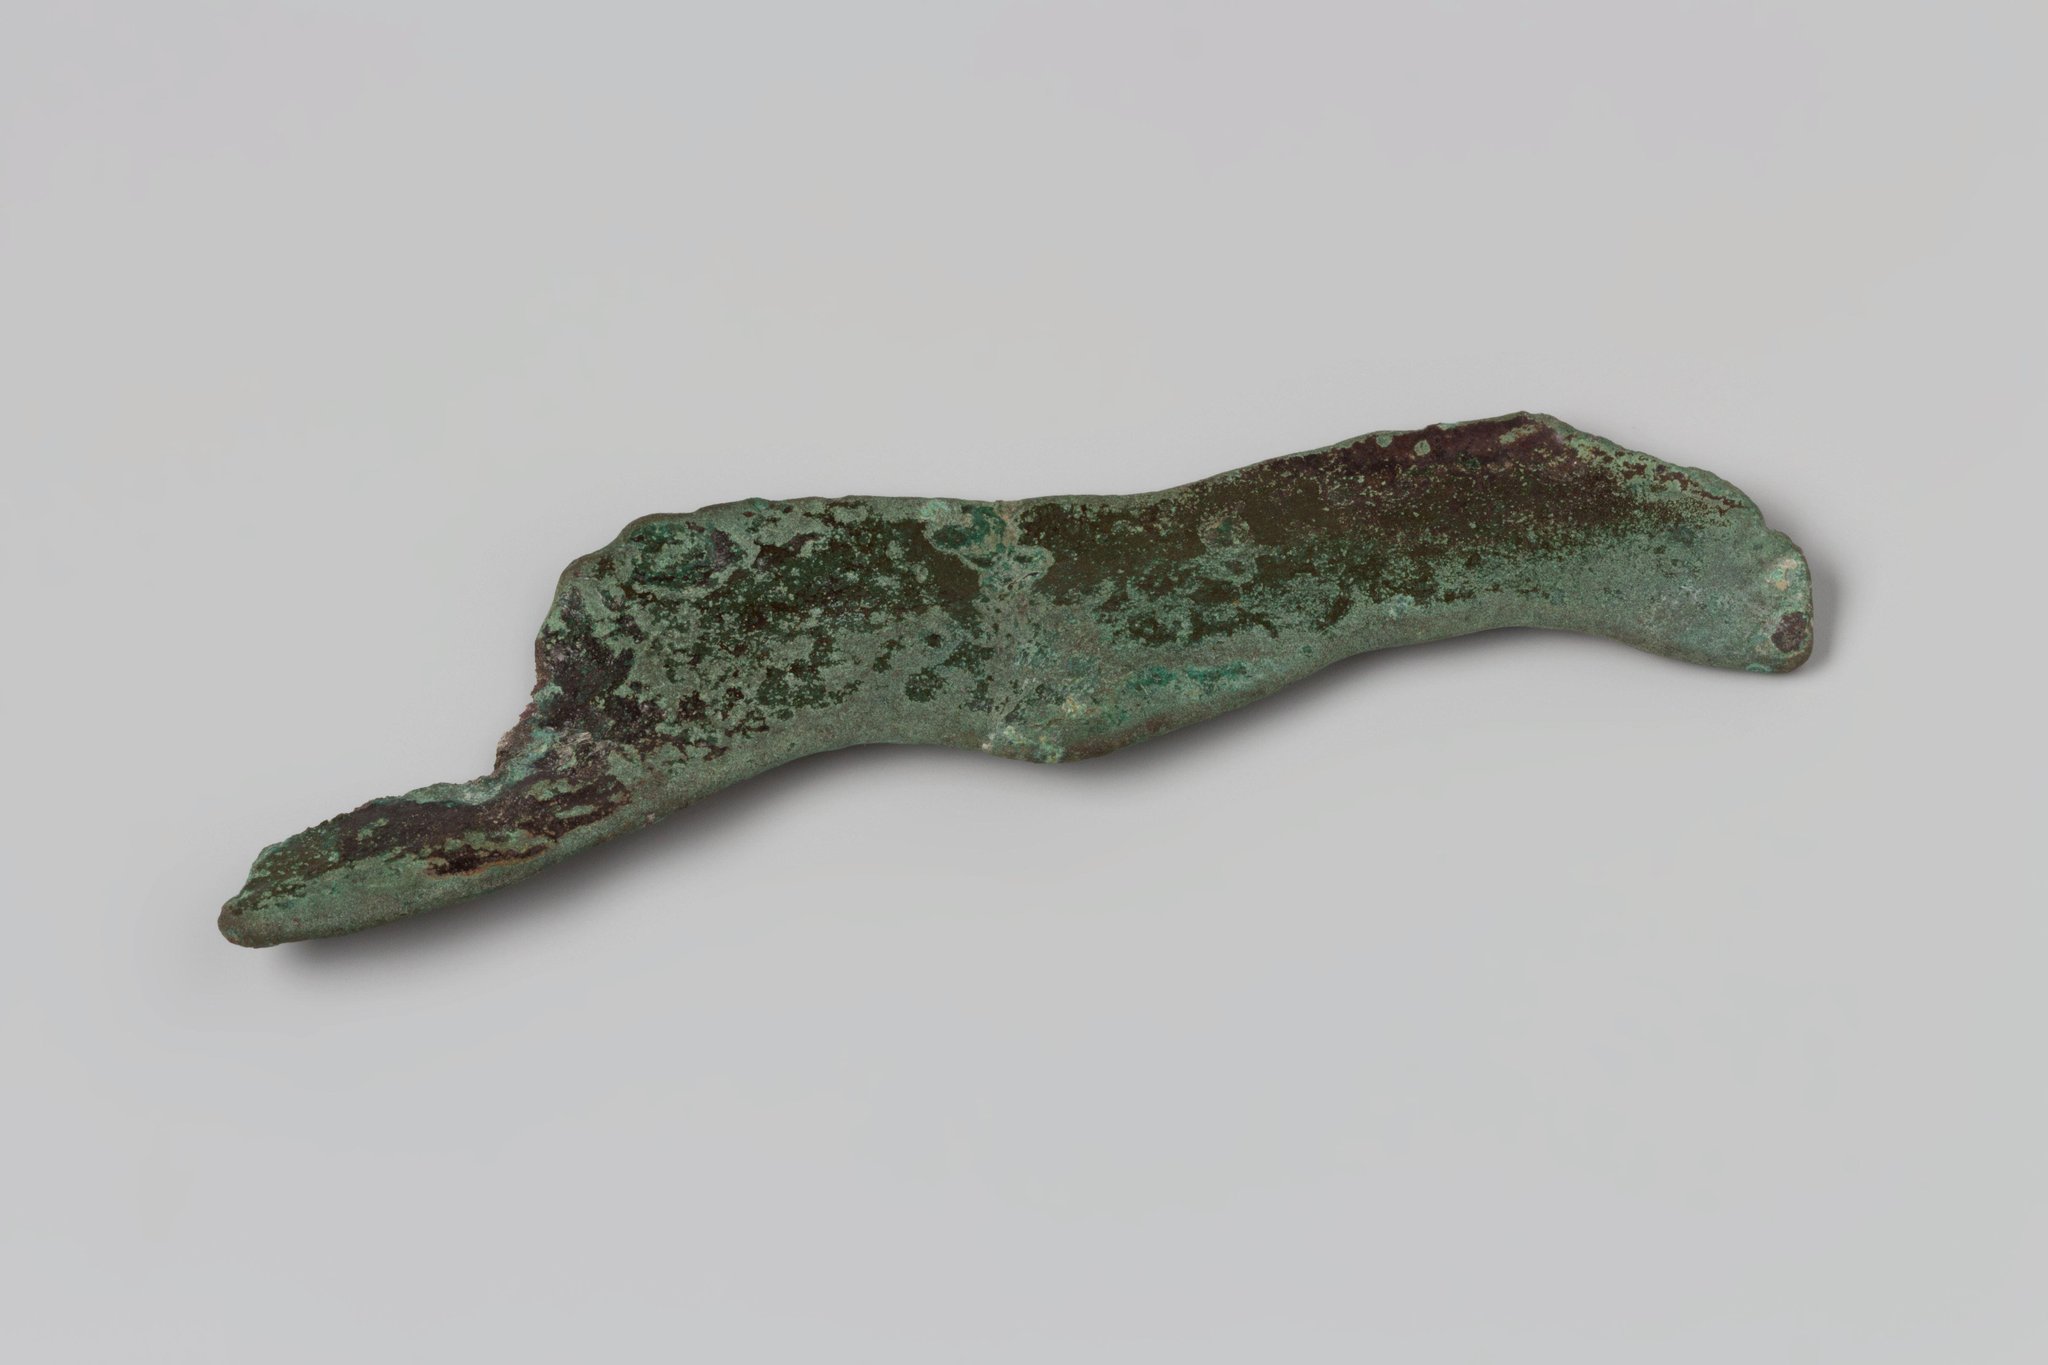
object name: scheepswrakvondst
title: Fragment van koper uit het wrak van de Oost-Indiëvaarder Hollandia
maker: Anonymous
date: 1700-1743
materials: copper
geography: netherlands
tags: verenigde oostindische compagnie, hollandia (schip), annet